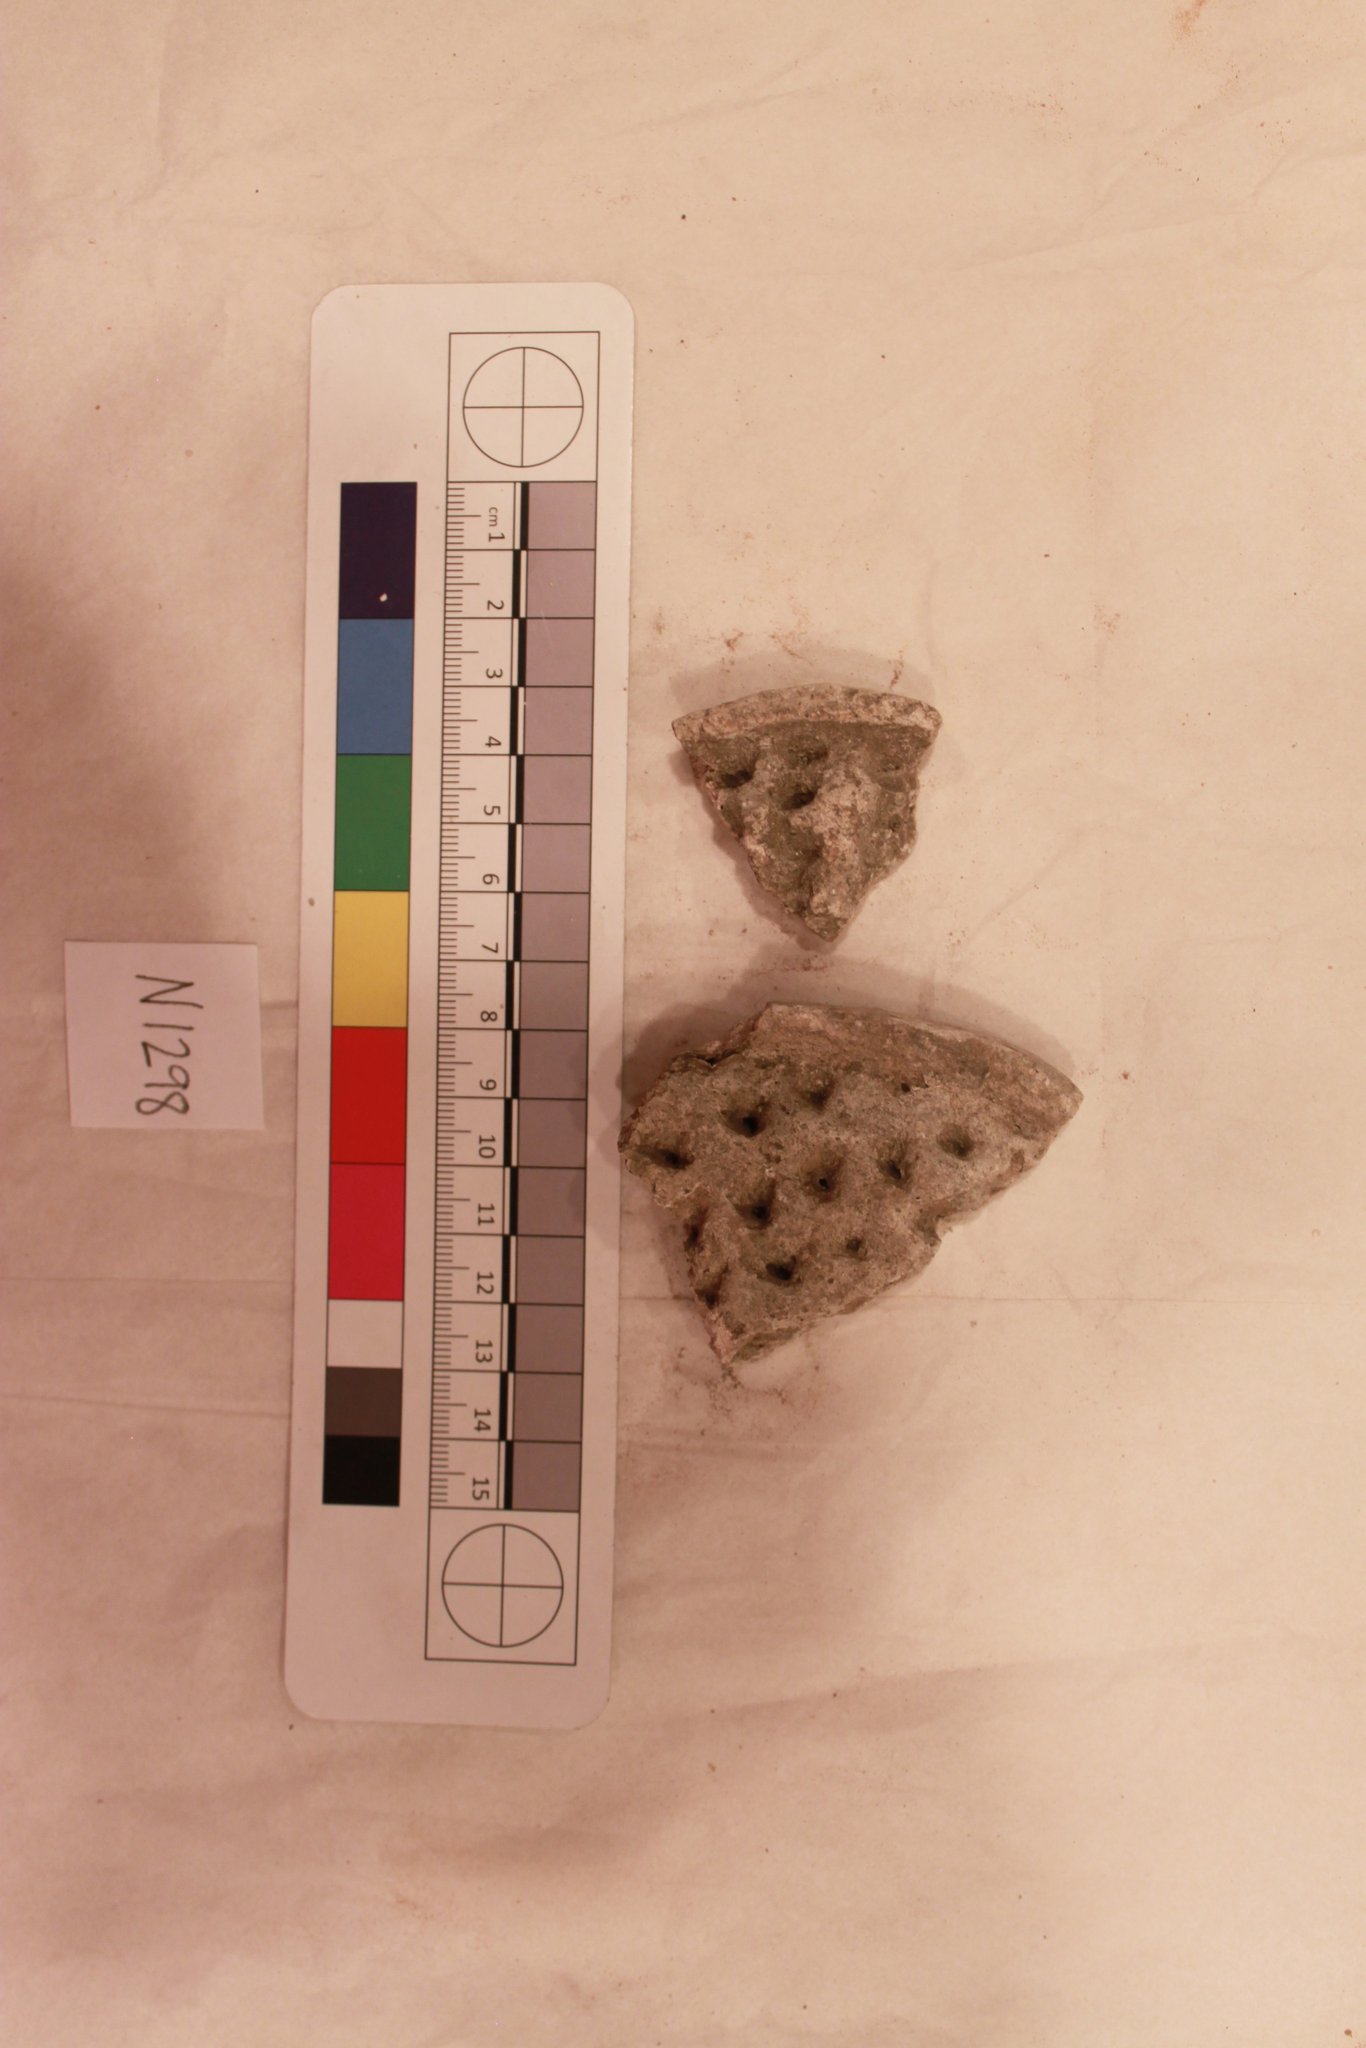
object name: fragment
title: Stucco Fragment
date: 701-1200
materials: plaster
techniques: carving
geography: iran